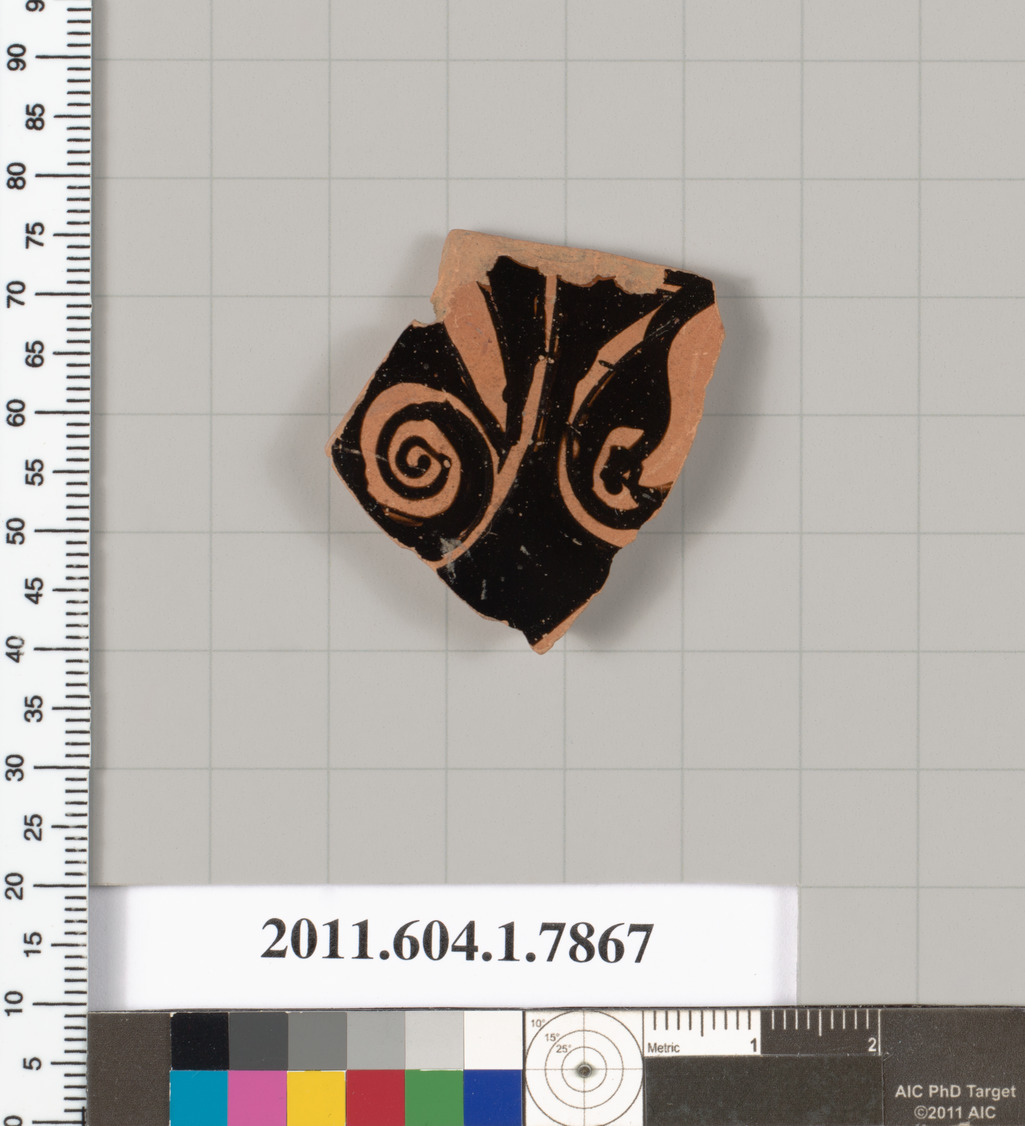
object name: kylix fragment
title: Terracotta fragment of a kylix (drinking cup)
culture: greek, attic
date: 440-420 BCE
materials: terracotta